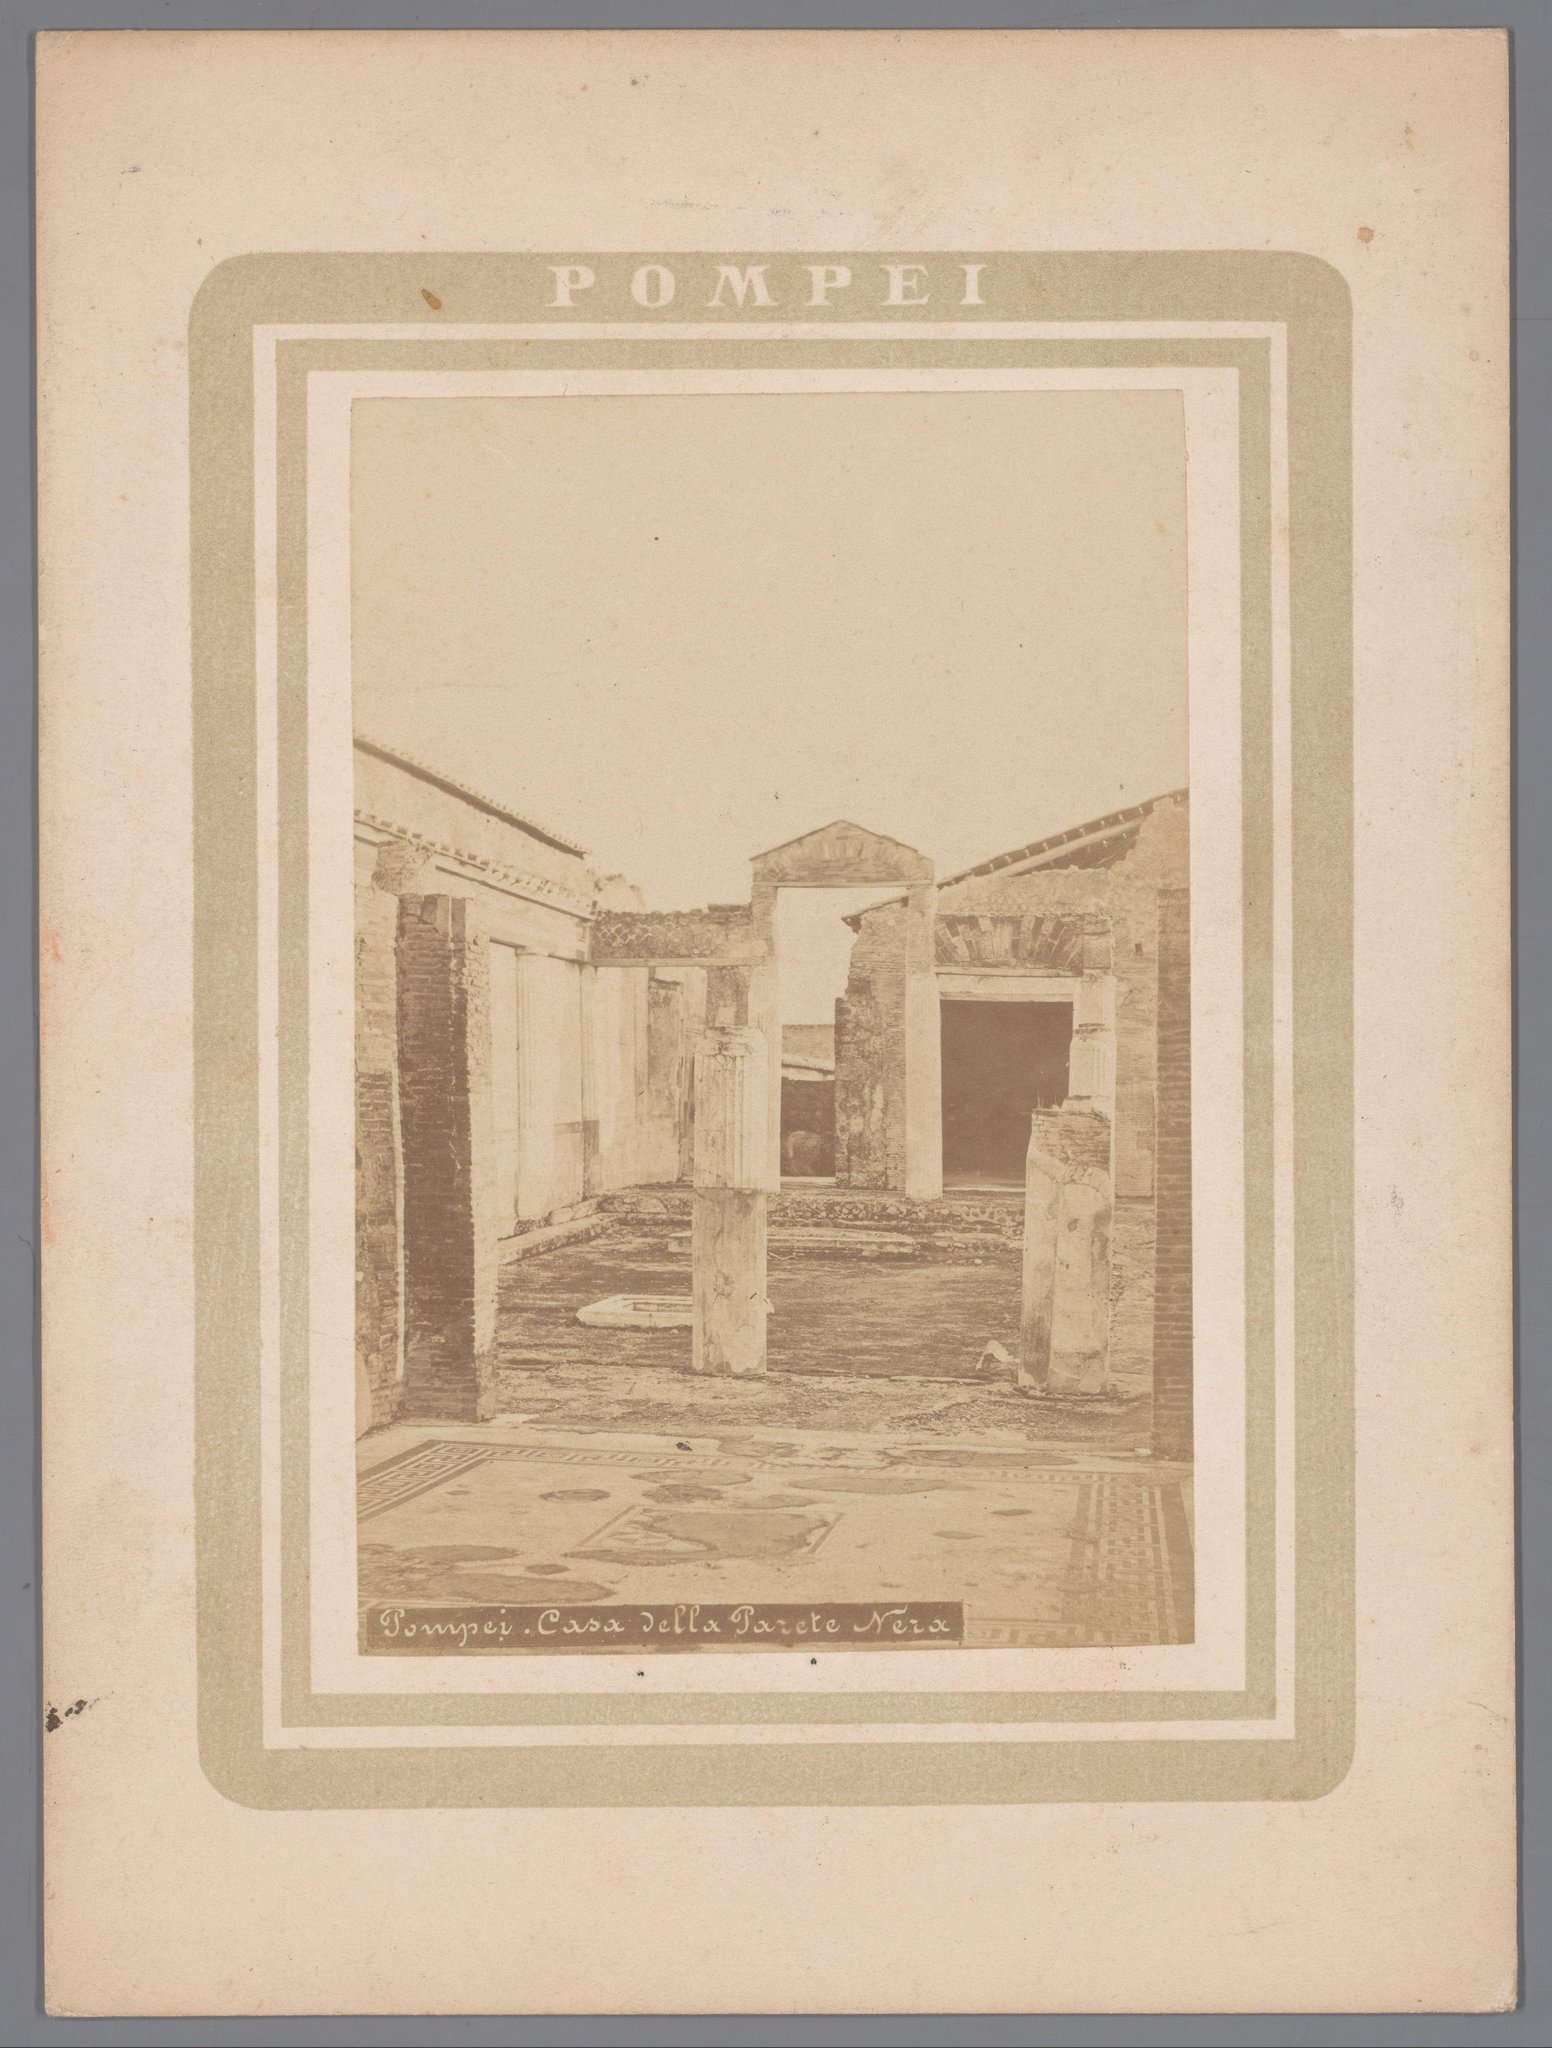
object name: photograph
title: Restanten van Casa della Pareta Nera te Pompeï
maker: giorgio sommer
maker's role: fotograaf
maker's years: 1834-1914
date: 1857-1914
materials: cardboard, paper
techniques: albumen print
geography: pompeii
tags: urban housing, ruin of a building ~ architecture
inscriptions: inscription: ‘10’, collector's mark: ‘VOSMAER’